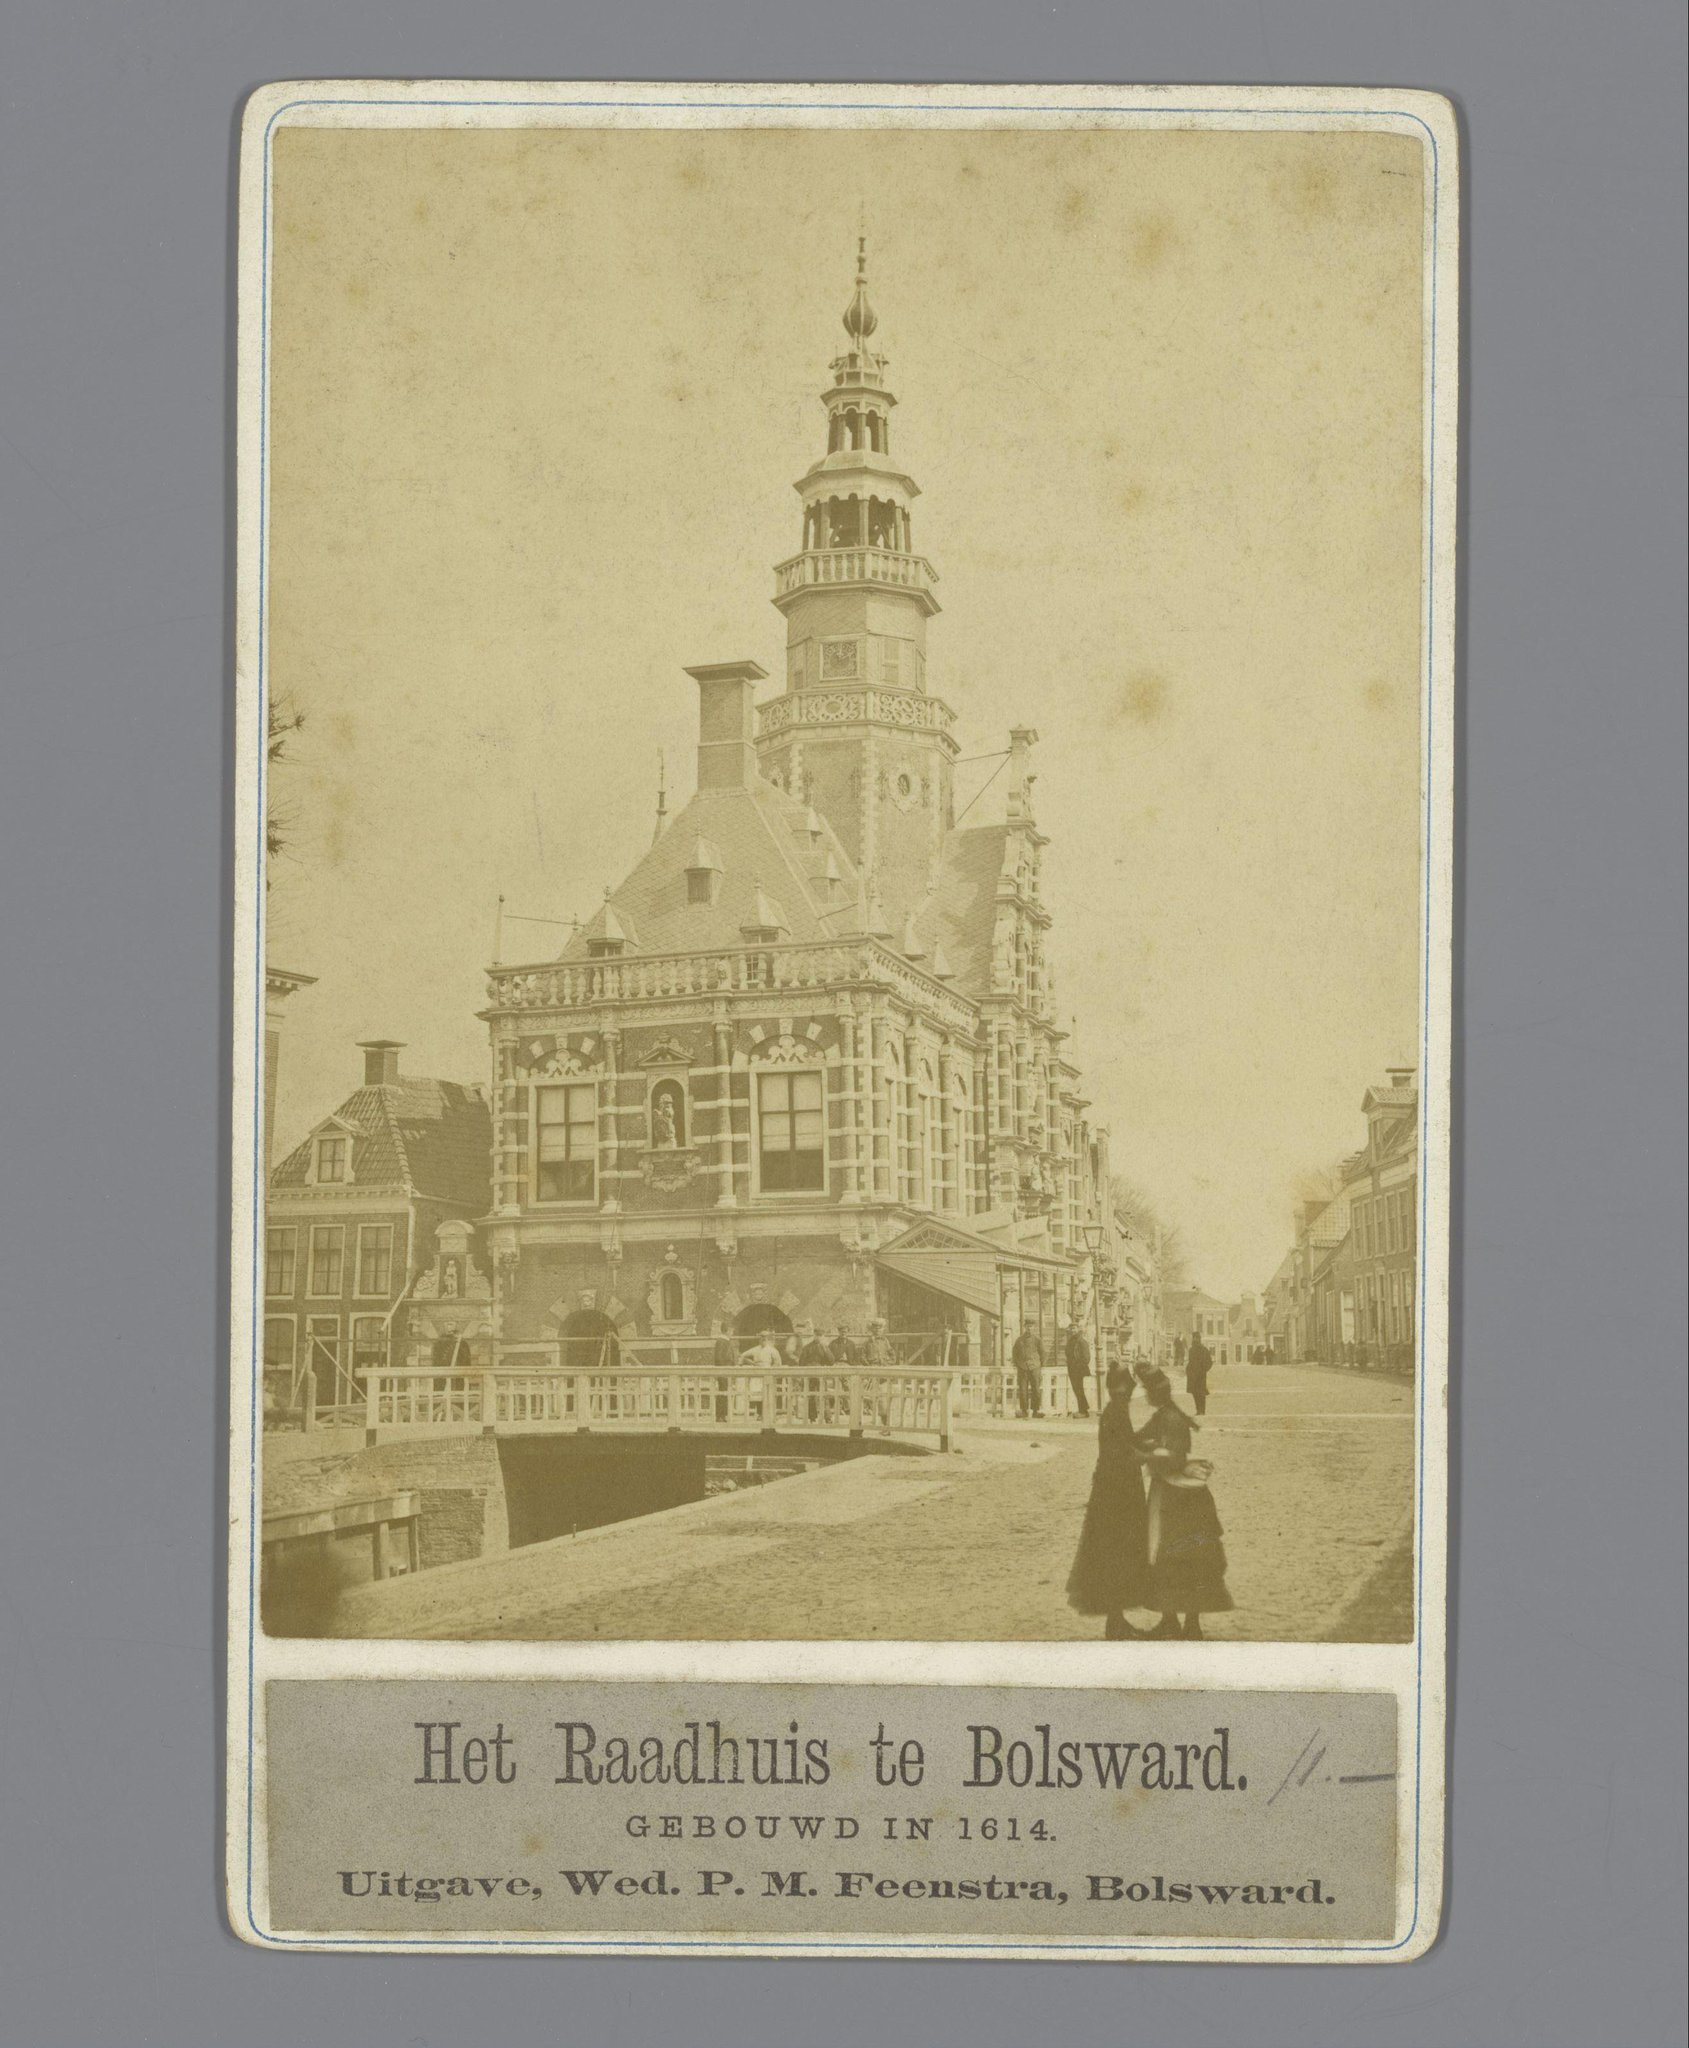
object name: photograph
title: Stadhuis te Bolsward, Friesland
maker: Anonymous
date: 1860-1896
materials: cardboard, photographic support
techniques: albumen print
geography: bolsward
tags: townhall, street (+ city(-scape) with figures, staffage)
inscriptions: annotation: ‘Bolsward 22/8 '83.-/ top.’, inscription: ‘Het Raadhuis te Bolsward. / GEBOUWD IN 1614. / Uitgave, Wed. P.M. Feenstra, Bolsward.’